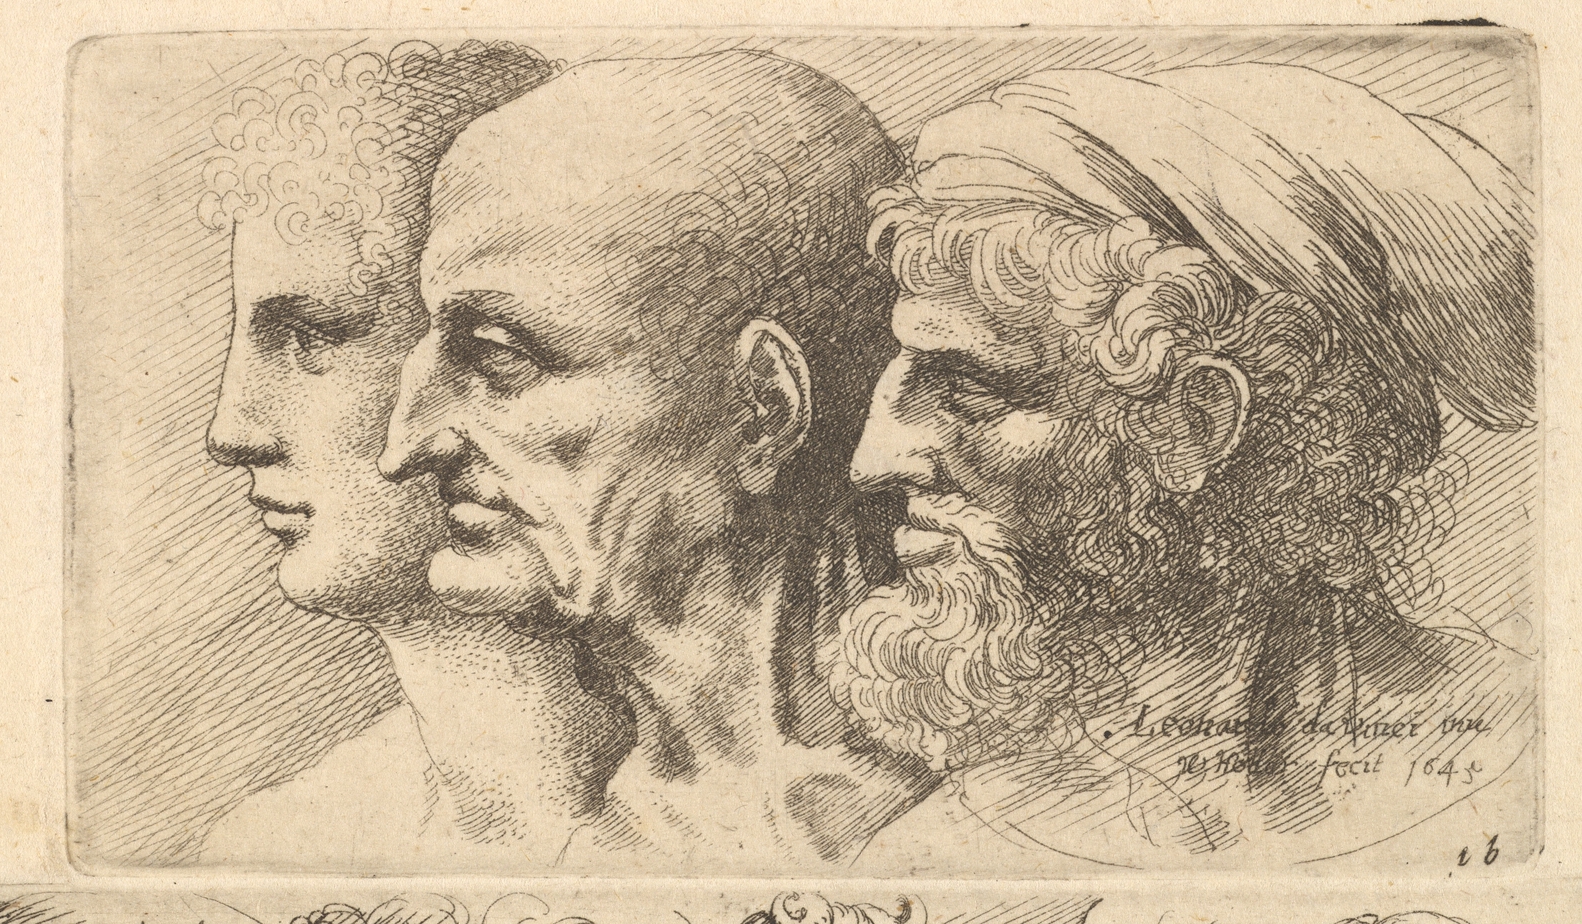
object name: print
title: Row of three heads in profile to left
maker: wenceslaus hollar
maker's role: artist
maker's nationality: bohemian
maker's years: 1607-1677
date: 1645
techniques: etching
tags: heads,men